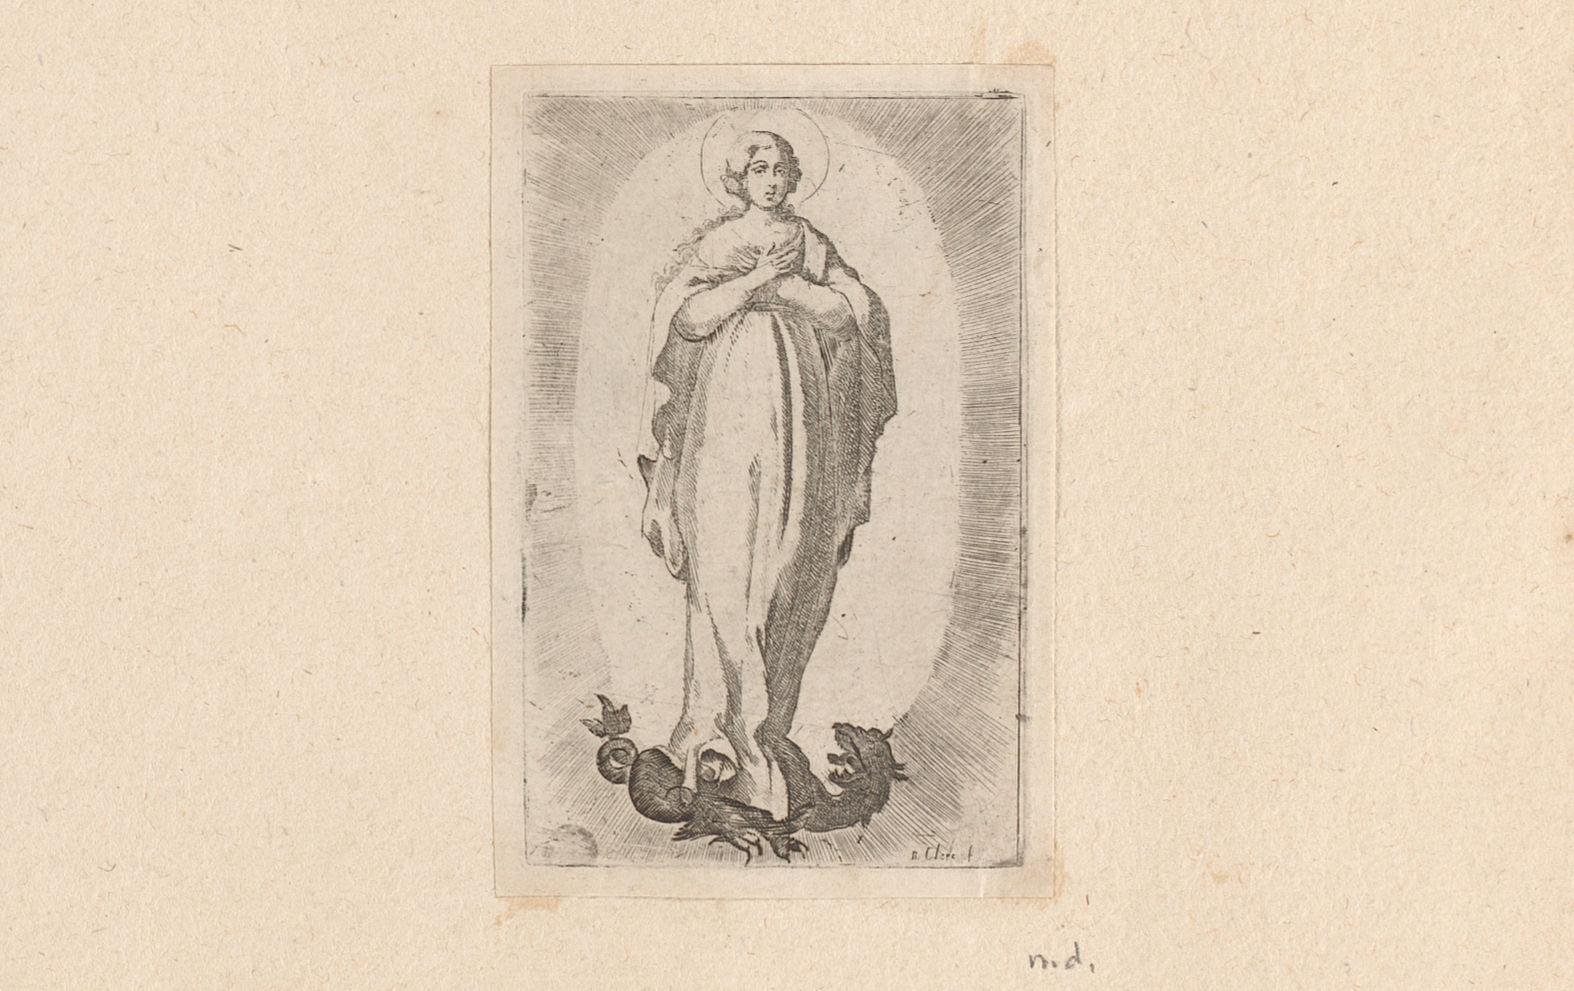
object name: album leaf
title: Onbevlekte Ontvangenis van Maria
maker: sébastien leclerc (i)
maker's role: print maker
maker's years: 1637-1714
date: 1647-1714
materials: paper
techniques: etching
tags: 'immaculata', 'purisima': mary, usually standing on a crescent moon, descending from heaven, exempt from original sin (sometimes trampling serpent)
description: Prent niet beschreven in IFF 17e siècle, maar toont overeenkomsten met nr. 63 in deel 8, p. 50.